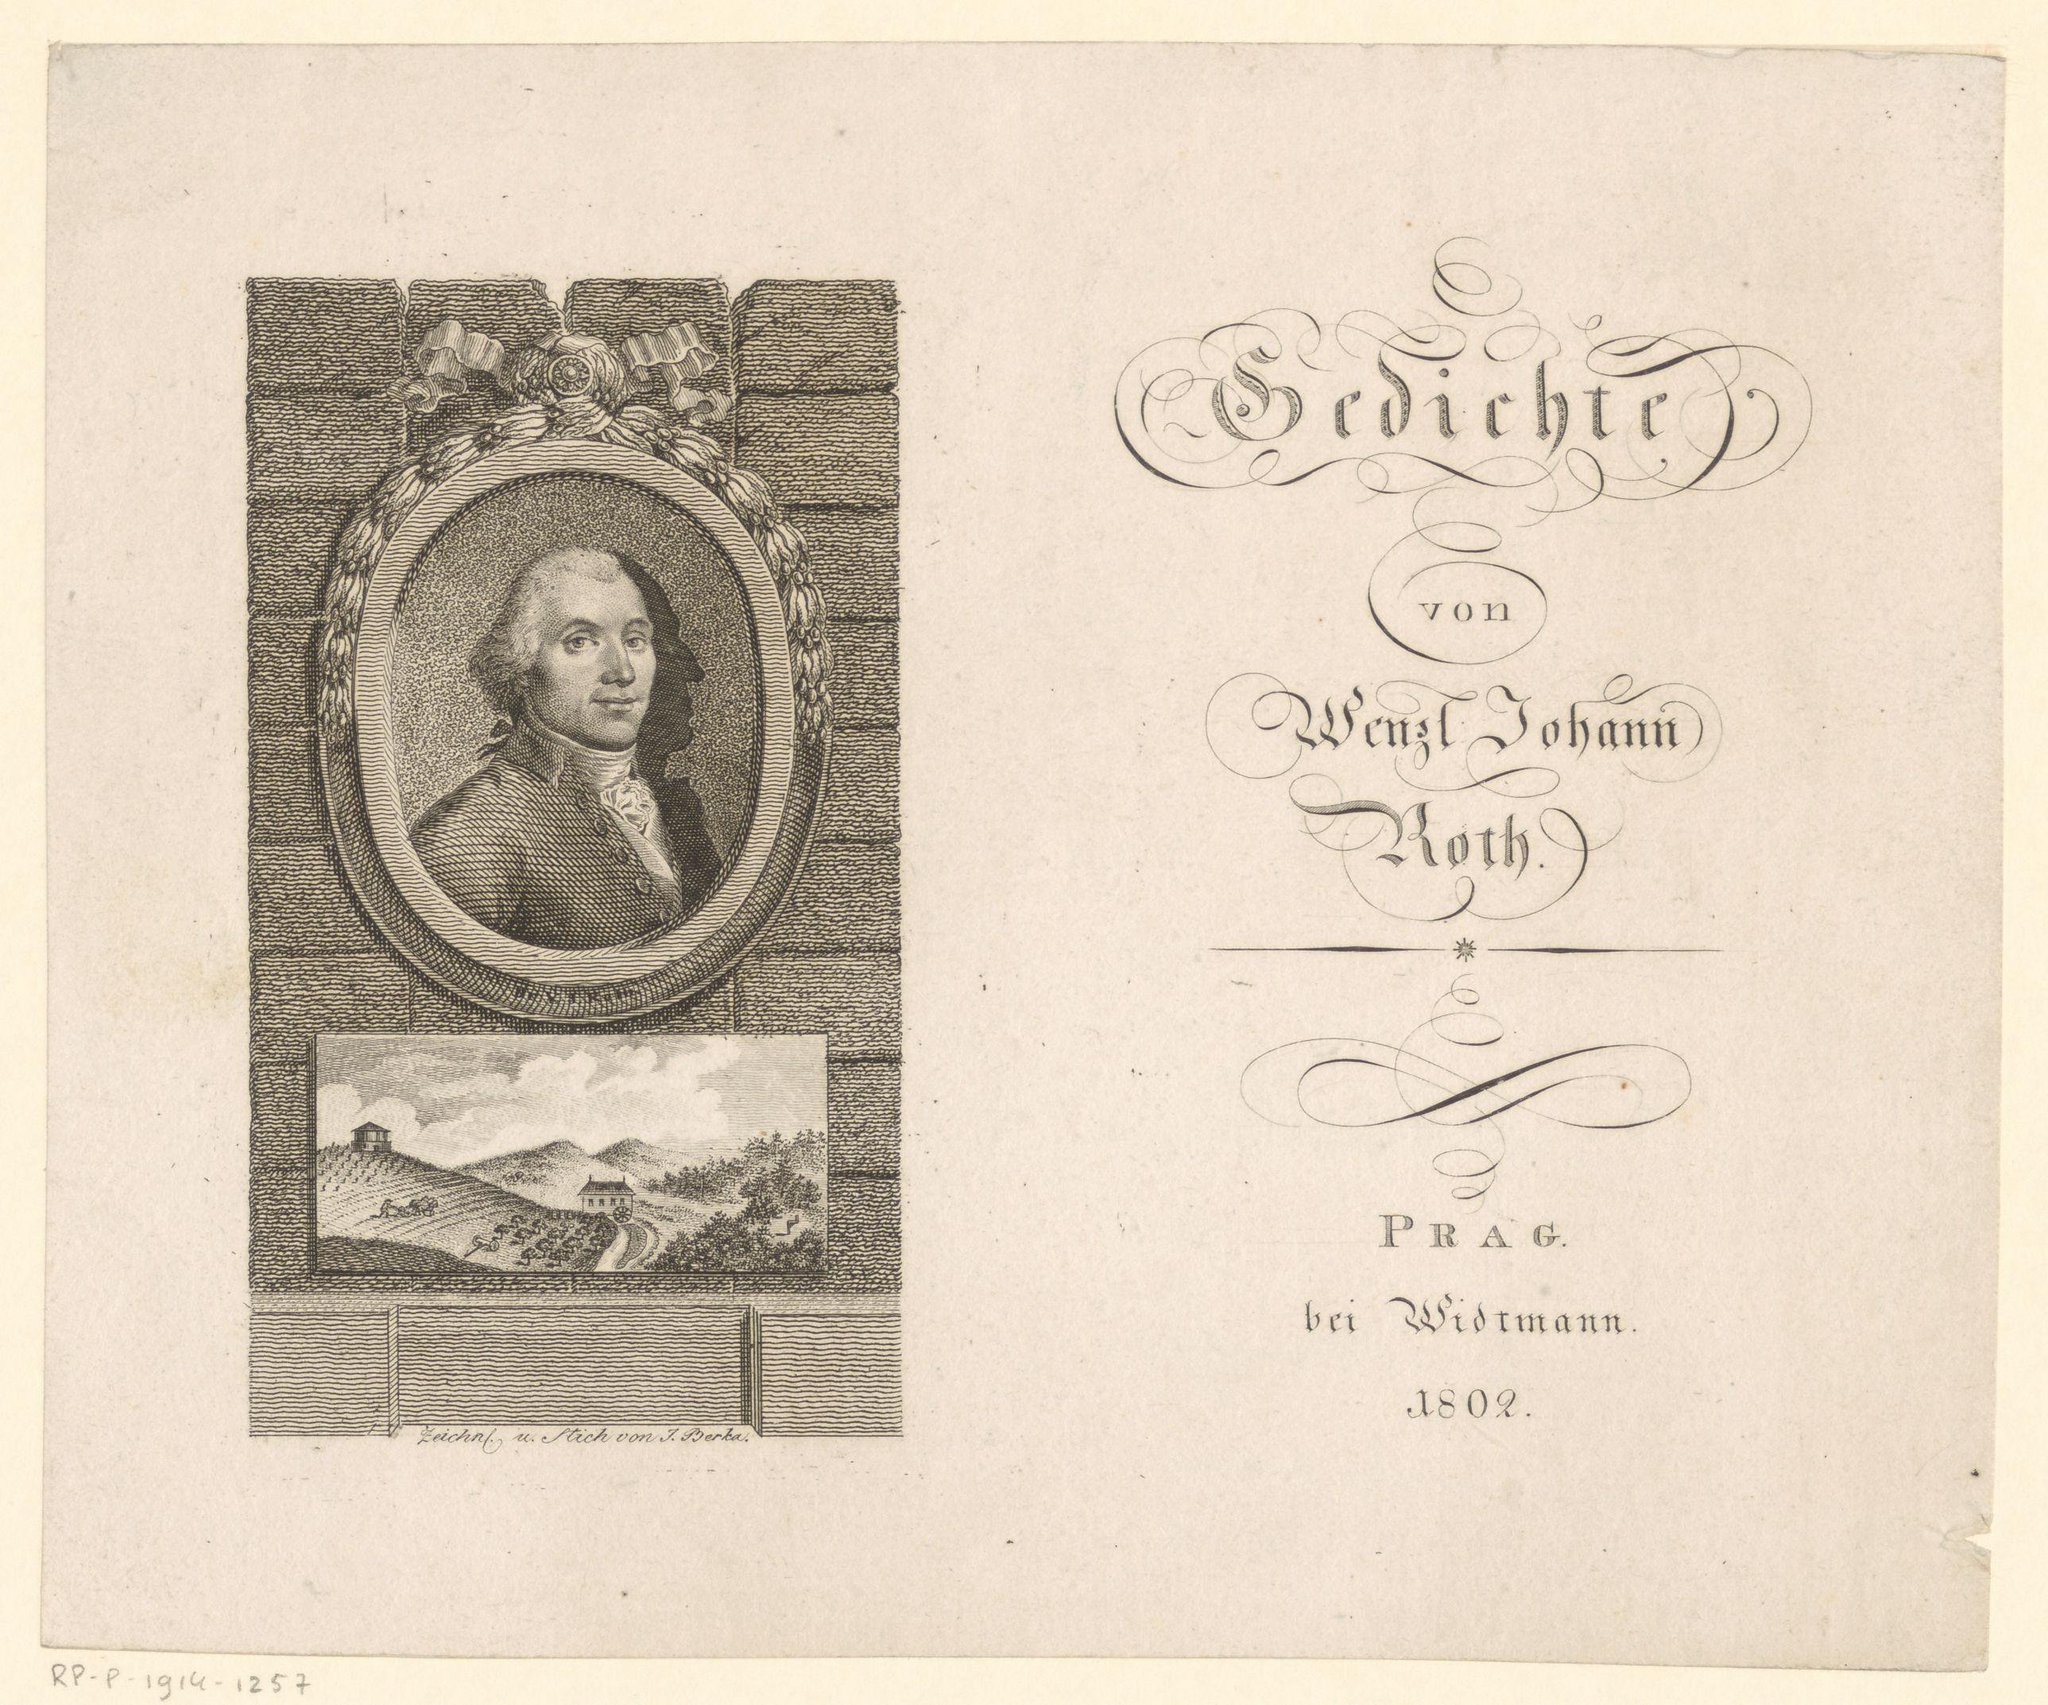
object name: print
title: Titelpagina voor: Johann Roth, Gedichte, 1802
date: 1802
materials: paper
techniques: engraving, etching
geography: prague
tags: landscapes, historical persons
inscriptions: collector's mark: Lugt 2228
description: Titelpagina voor: Roth, Johann. Gedichte. Praag: Kaspar Widtmann, 1802.